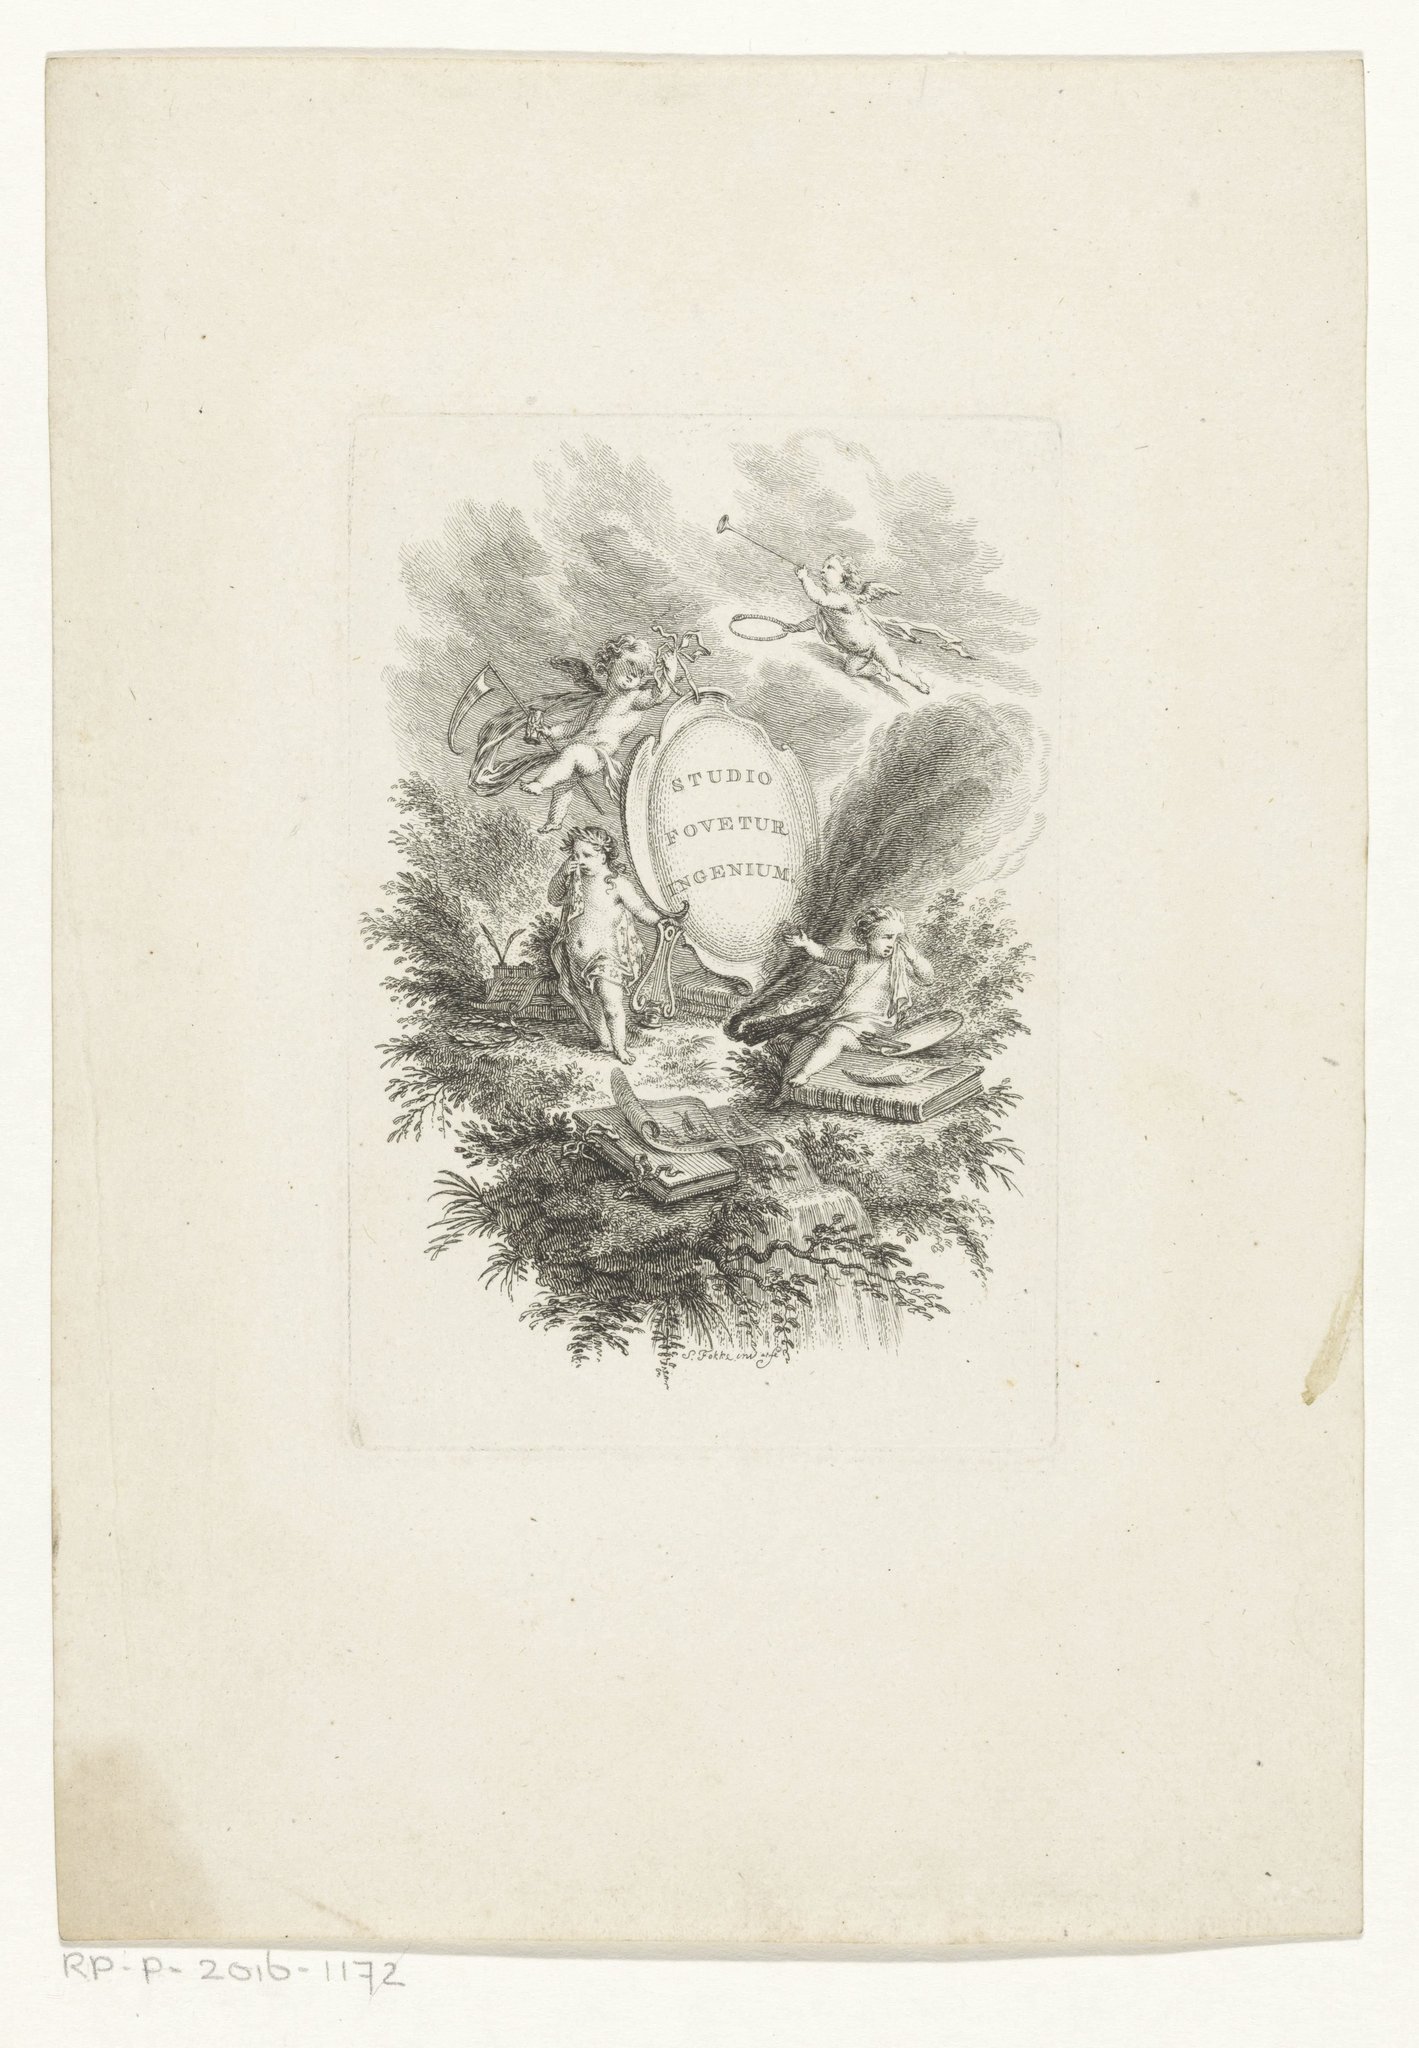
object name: titelblad, titelpagina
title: Vier putti rond een cartouche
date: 1764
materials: paper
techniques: etching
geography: amsterdam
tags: ornament ~ cartouche, cupids: 'amores', 'amoretti', 'putti'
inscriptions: collector's mark: Lugt 2228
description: Vier putti rond een cartouche met het opschrift: Studio Fovetur Ingenium. Op de grond bevinden zich twee huilende putti, één met lier en één met schilderspalet en penselen. De cartouche wordt omhoog gehouden door een vliegende putto met zeis en zandloper. In de lucht vliegt een bazuin blazende putto met het symbool van eeuwigheid in zijn hand.